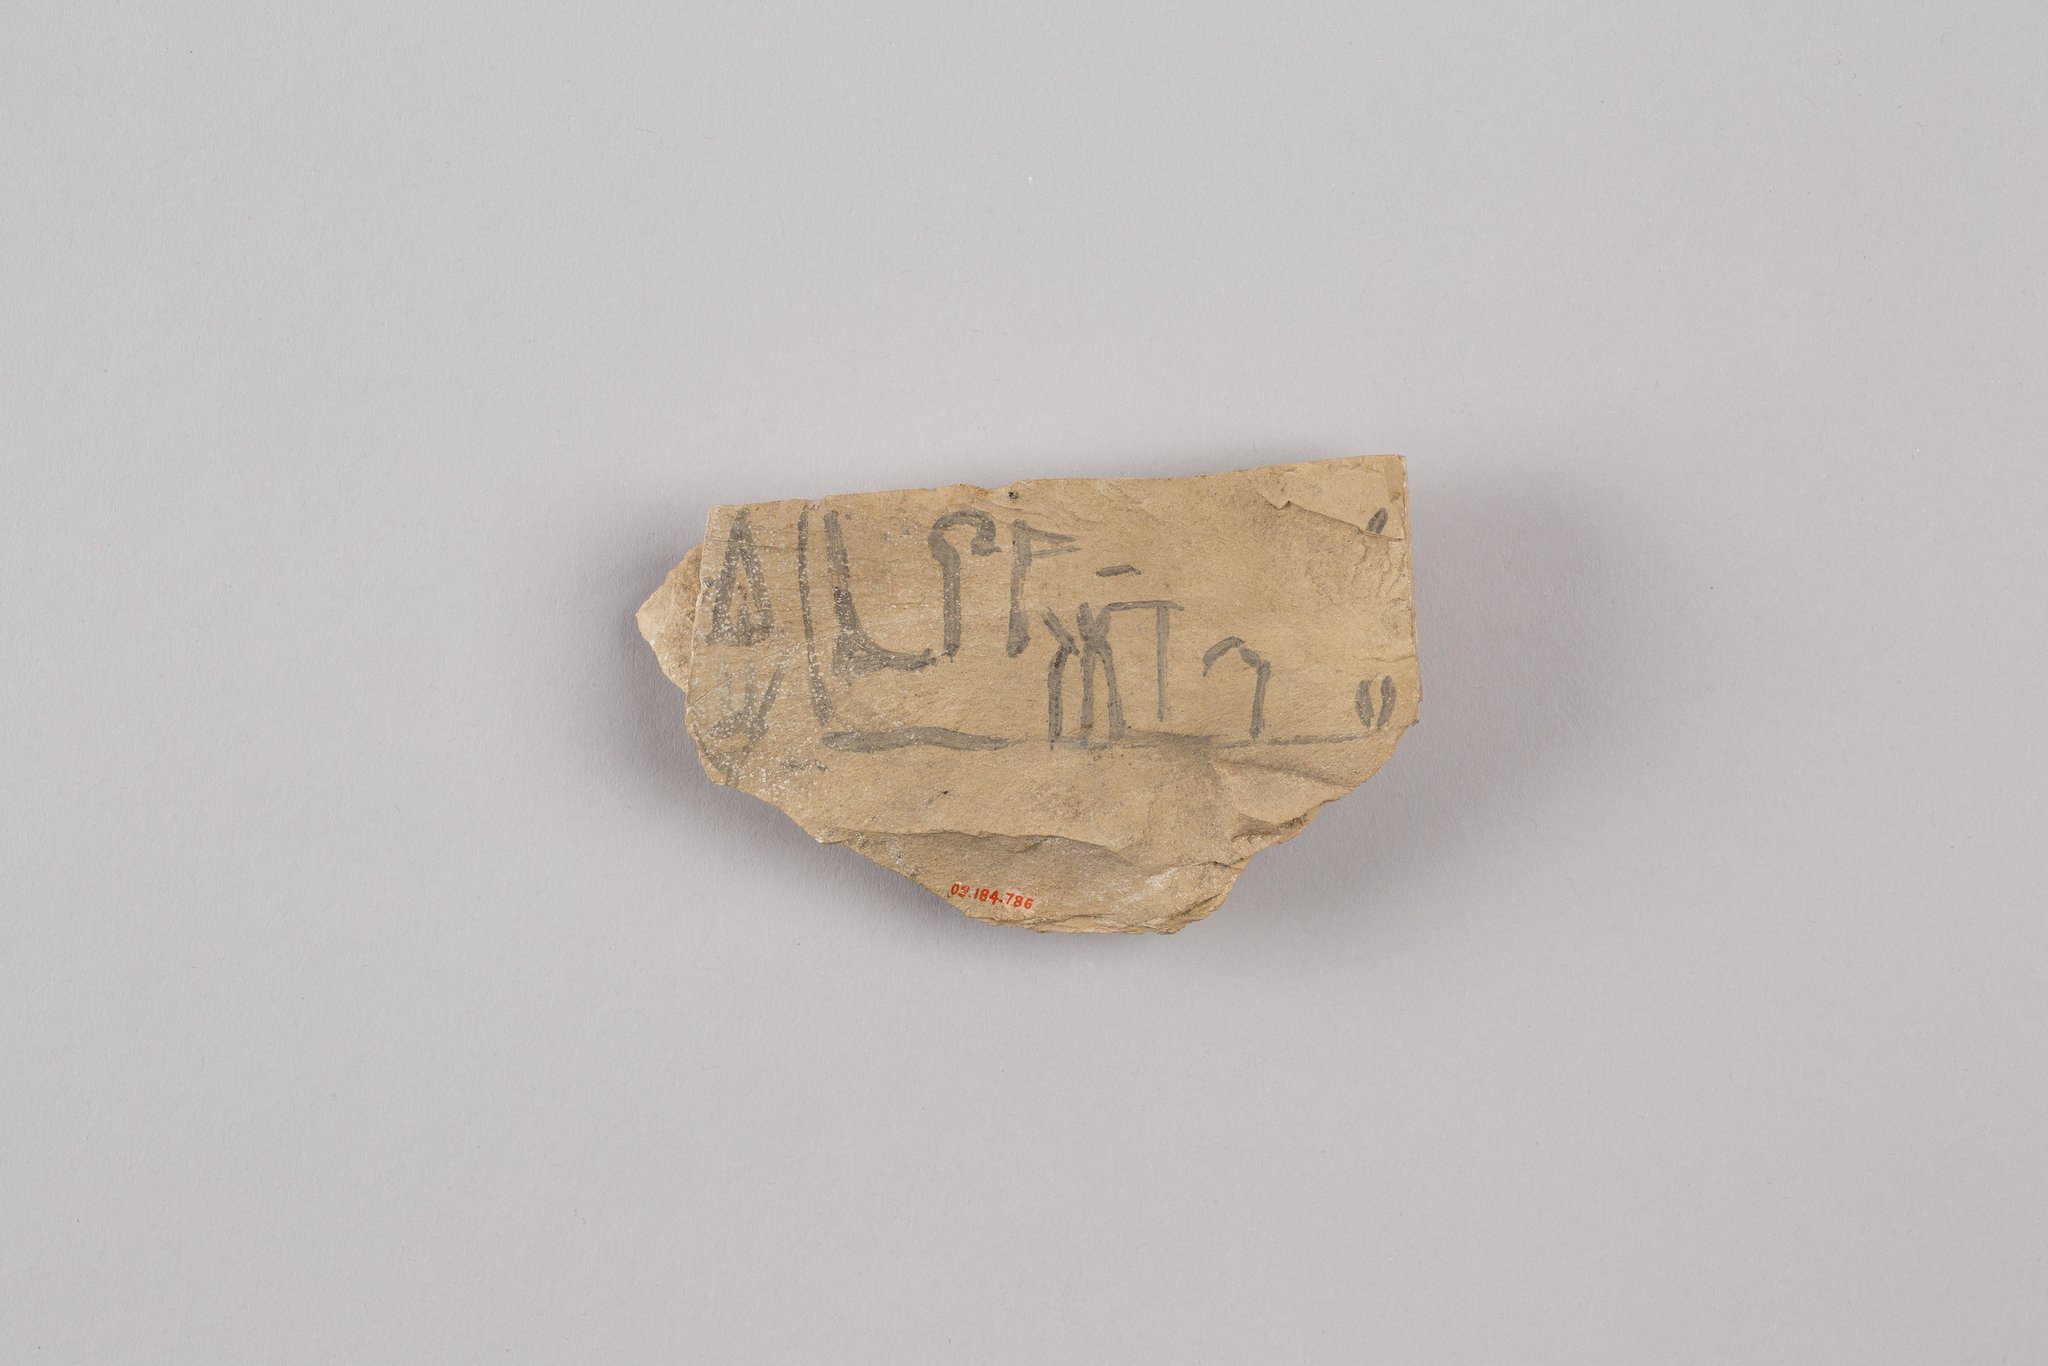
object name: ostracon, identity, mark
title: Hieroglyph ostracon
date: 1427-1352 BCE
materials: ink, limestone, paint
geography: egypt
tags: hieroglyphs